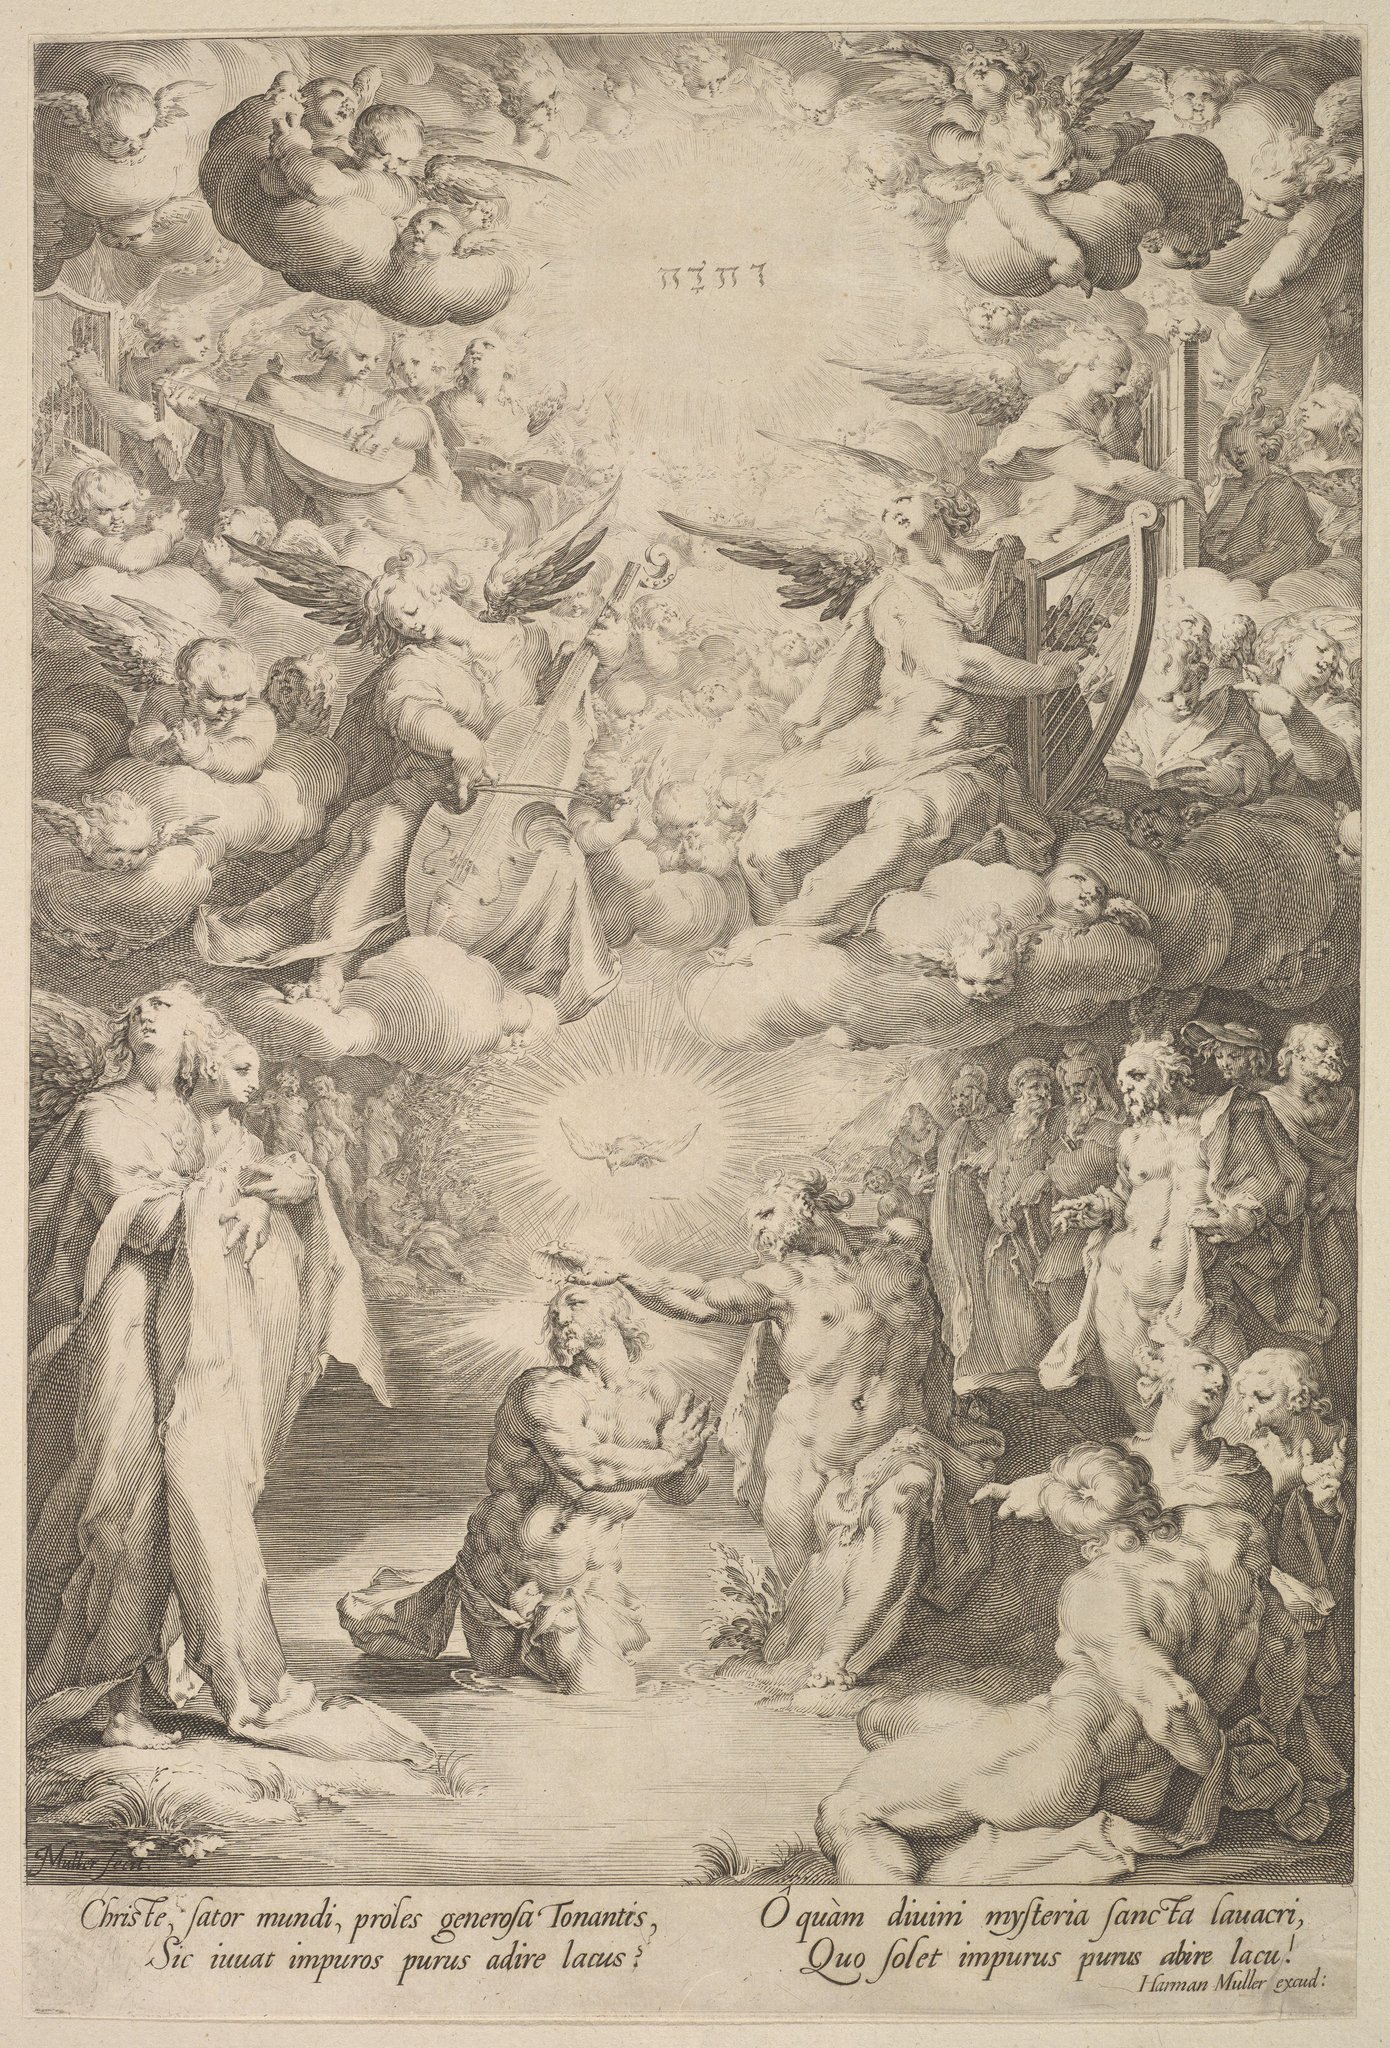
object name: print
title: The Baptism of Christ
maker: jan muller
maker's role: artist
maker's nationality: netherlandish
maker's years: 1571-1628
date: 1590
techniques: engraving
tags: musical instruments,male nudes,angels,baptism of christ